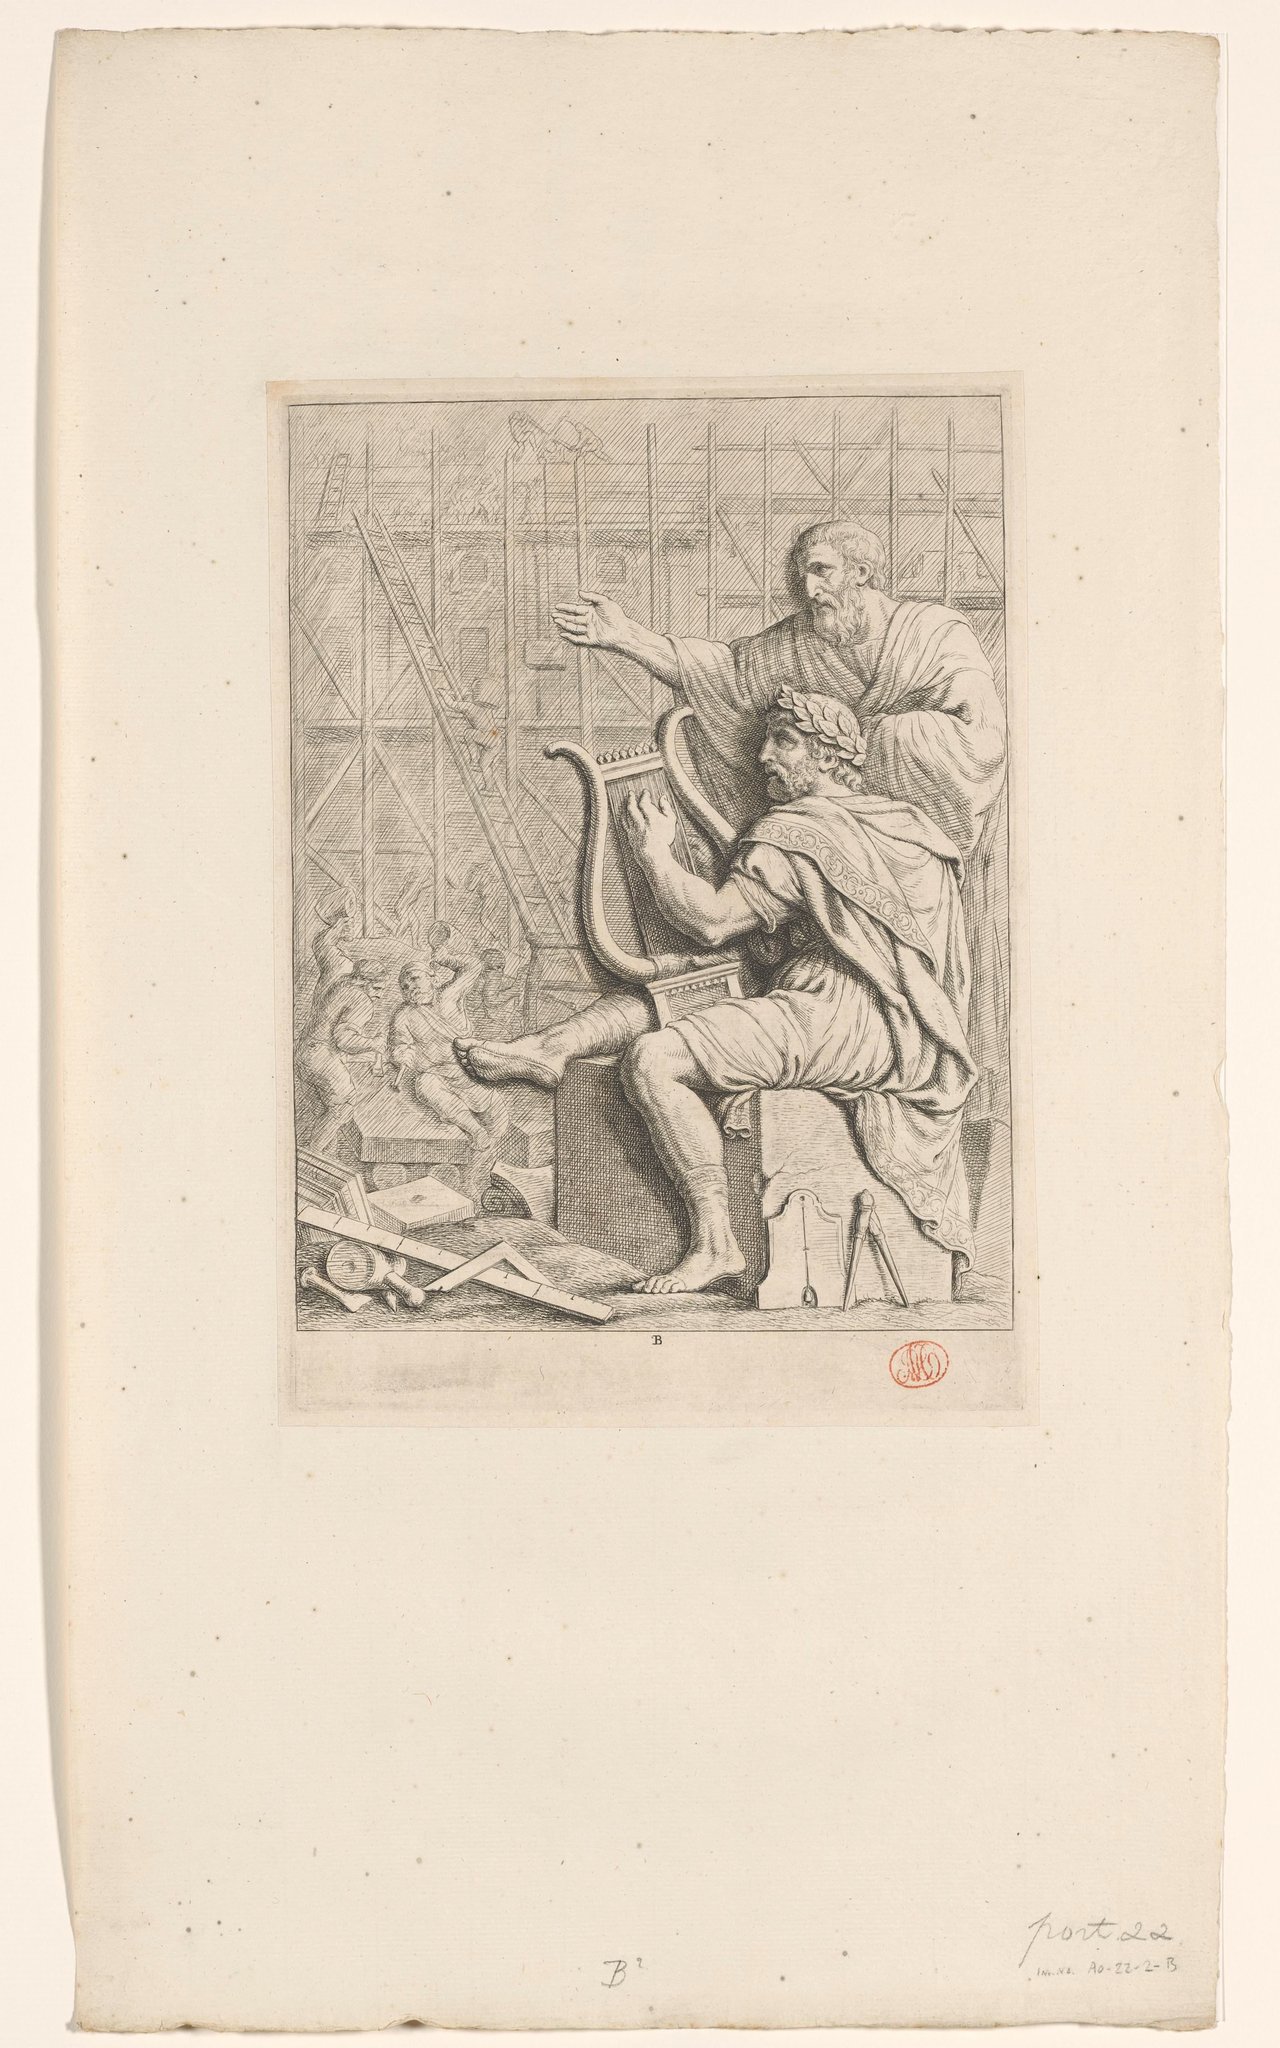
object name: book illustration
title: Reliëf met Amphion en Zethos in de Burgerzaal van het Stadhuis op de Dam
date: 1663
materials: paper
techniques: engraving, etching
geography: amsterdam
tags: amphion building the walls of thebes (without zethus), measuring-instruments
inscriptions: collector's mark: Lugt 195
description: Prent gebruikt in: Secunca pars Praecipuarum effigierum ac ornamentorum amplissime Curiae Amstelrodamensis maiori ex parte in cadido marmore effectorum per Artum Quellinium eiusdem Civitatis Statuarium / Het tweede deel Van de voornaemste Statuen ende Cieraten van 't konst-rijcke Stadt-huys van Amstelredam 'tmeeste in Marmer gemaeckt door Artus Quellinus Beelthouwer der voorseyde Stadt. Amsterdam: Artus Quellinus (I), 1663. Zie RP-P-AO-22-2-1 voor bijhorende titelpagina. Zie RP-P-AO-22-2-2 voor bijhorend register. Zie RP-P-AO-22-2A, RP-P-AO-22-2C-1, RP-P-AO-22-2C-2, RP-P-AO-22-2C-3, RP-P-AO-22-2C-4, RP-P-AO-22-2D-1, RP-P-AO-22-2D-2, RP-P-AO-22-2D-3, RP-P-AO-22-2E-1, RP-P-AO-22-2E-2, RP-P-AO-22-2E-3, RP-P-AO-22-2E-4, RP-P-AO-22-2F-1, RP-P-AO-22-2F-2, RP-P-AO-22-2F-3, RP-P-AO-22-2G, RP-P-AO-22-2H, RP-P-AO-22-2I, RP-P-AO-22-2K, RP-P-AO-22-2L, RP-P-AO-22-2M, RP-P-AO-22-2N, RP-P-AO-22-2O-1, RP-P-AO-22-2O-2, RP-P-AO-22-2O-3, RP-P-AO-22-2O-4, RP-P-AO-22-2O-5, RP-P-AO-22-2O-6, RP-P-AO-22-2O-7, RP-P-AO-22-2P-1, RP-P-AO-22-2P-2, RP-P-AO-22-2Q-1, RP-P-AO-22-2Q-2, RP-P-AO-22-2Q-3, RP-P-AO-22-2R-1, RP-P-AO-22-2R-2, RP-P-AO-22-2R-3, RP-P-AO-22-2S, RP-P-AO-22-2T-1, RP-P-AO-22-2T-2, RP-P-AO-22-2T-3, RP-P-AO-22-2T-4, RP-P-AO-22-2V-1, RP-P-AO-22-2V-2, RP-P-AO-22-2W-1, RP-P-AO-22-2W-2, RP-P-AO-22-2X-1, RP-P-AO-22-2X-2 en RP-P-AO-22-2X-3 voor andere prenten uit deze publicatie. Zelfde staat van prent ook gebruikt in: Secunca pars Praecipuarum effigierum ac ornamentorum amplissime Curiae Amstelrodamensis maiori ex parte in cadido marmore effectorum per Artum Quellinium eiusdem Civitatis Statuarium / Het tweede deel Van de voornaemste Statuen ende Cieraten van 't konst-rijcke Stadt-huys van Amstelredam 'tmeeste in Marmer gemaeckt door Artus Quellinus Beelthouwer der voorseyde Stadt. Amsterdam: Frederik de Wit, 1668. Latere staat van prent ook gebruikt in: Architecture peinture et sculpture de la Maison de Ville d'Amsterdam, representee en CIX. figures en taille-douce (…). Amsterdam: David Mortier, 1719. En in: Architecture peinture et sculpture de la Maison de Ville d'Amsterdam, representee en CIX. figures en taille-douce (…). Amsterdam: Gerard Valck, 1719. En in: Bouw schilder en beeldhouwkonst, van het Stadhuis te Amsteldam, vertoont in CIX figuuren (…). Amsterdam: Covens & Mortier & Covens Jr., s.a. (1774-1783).